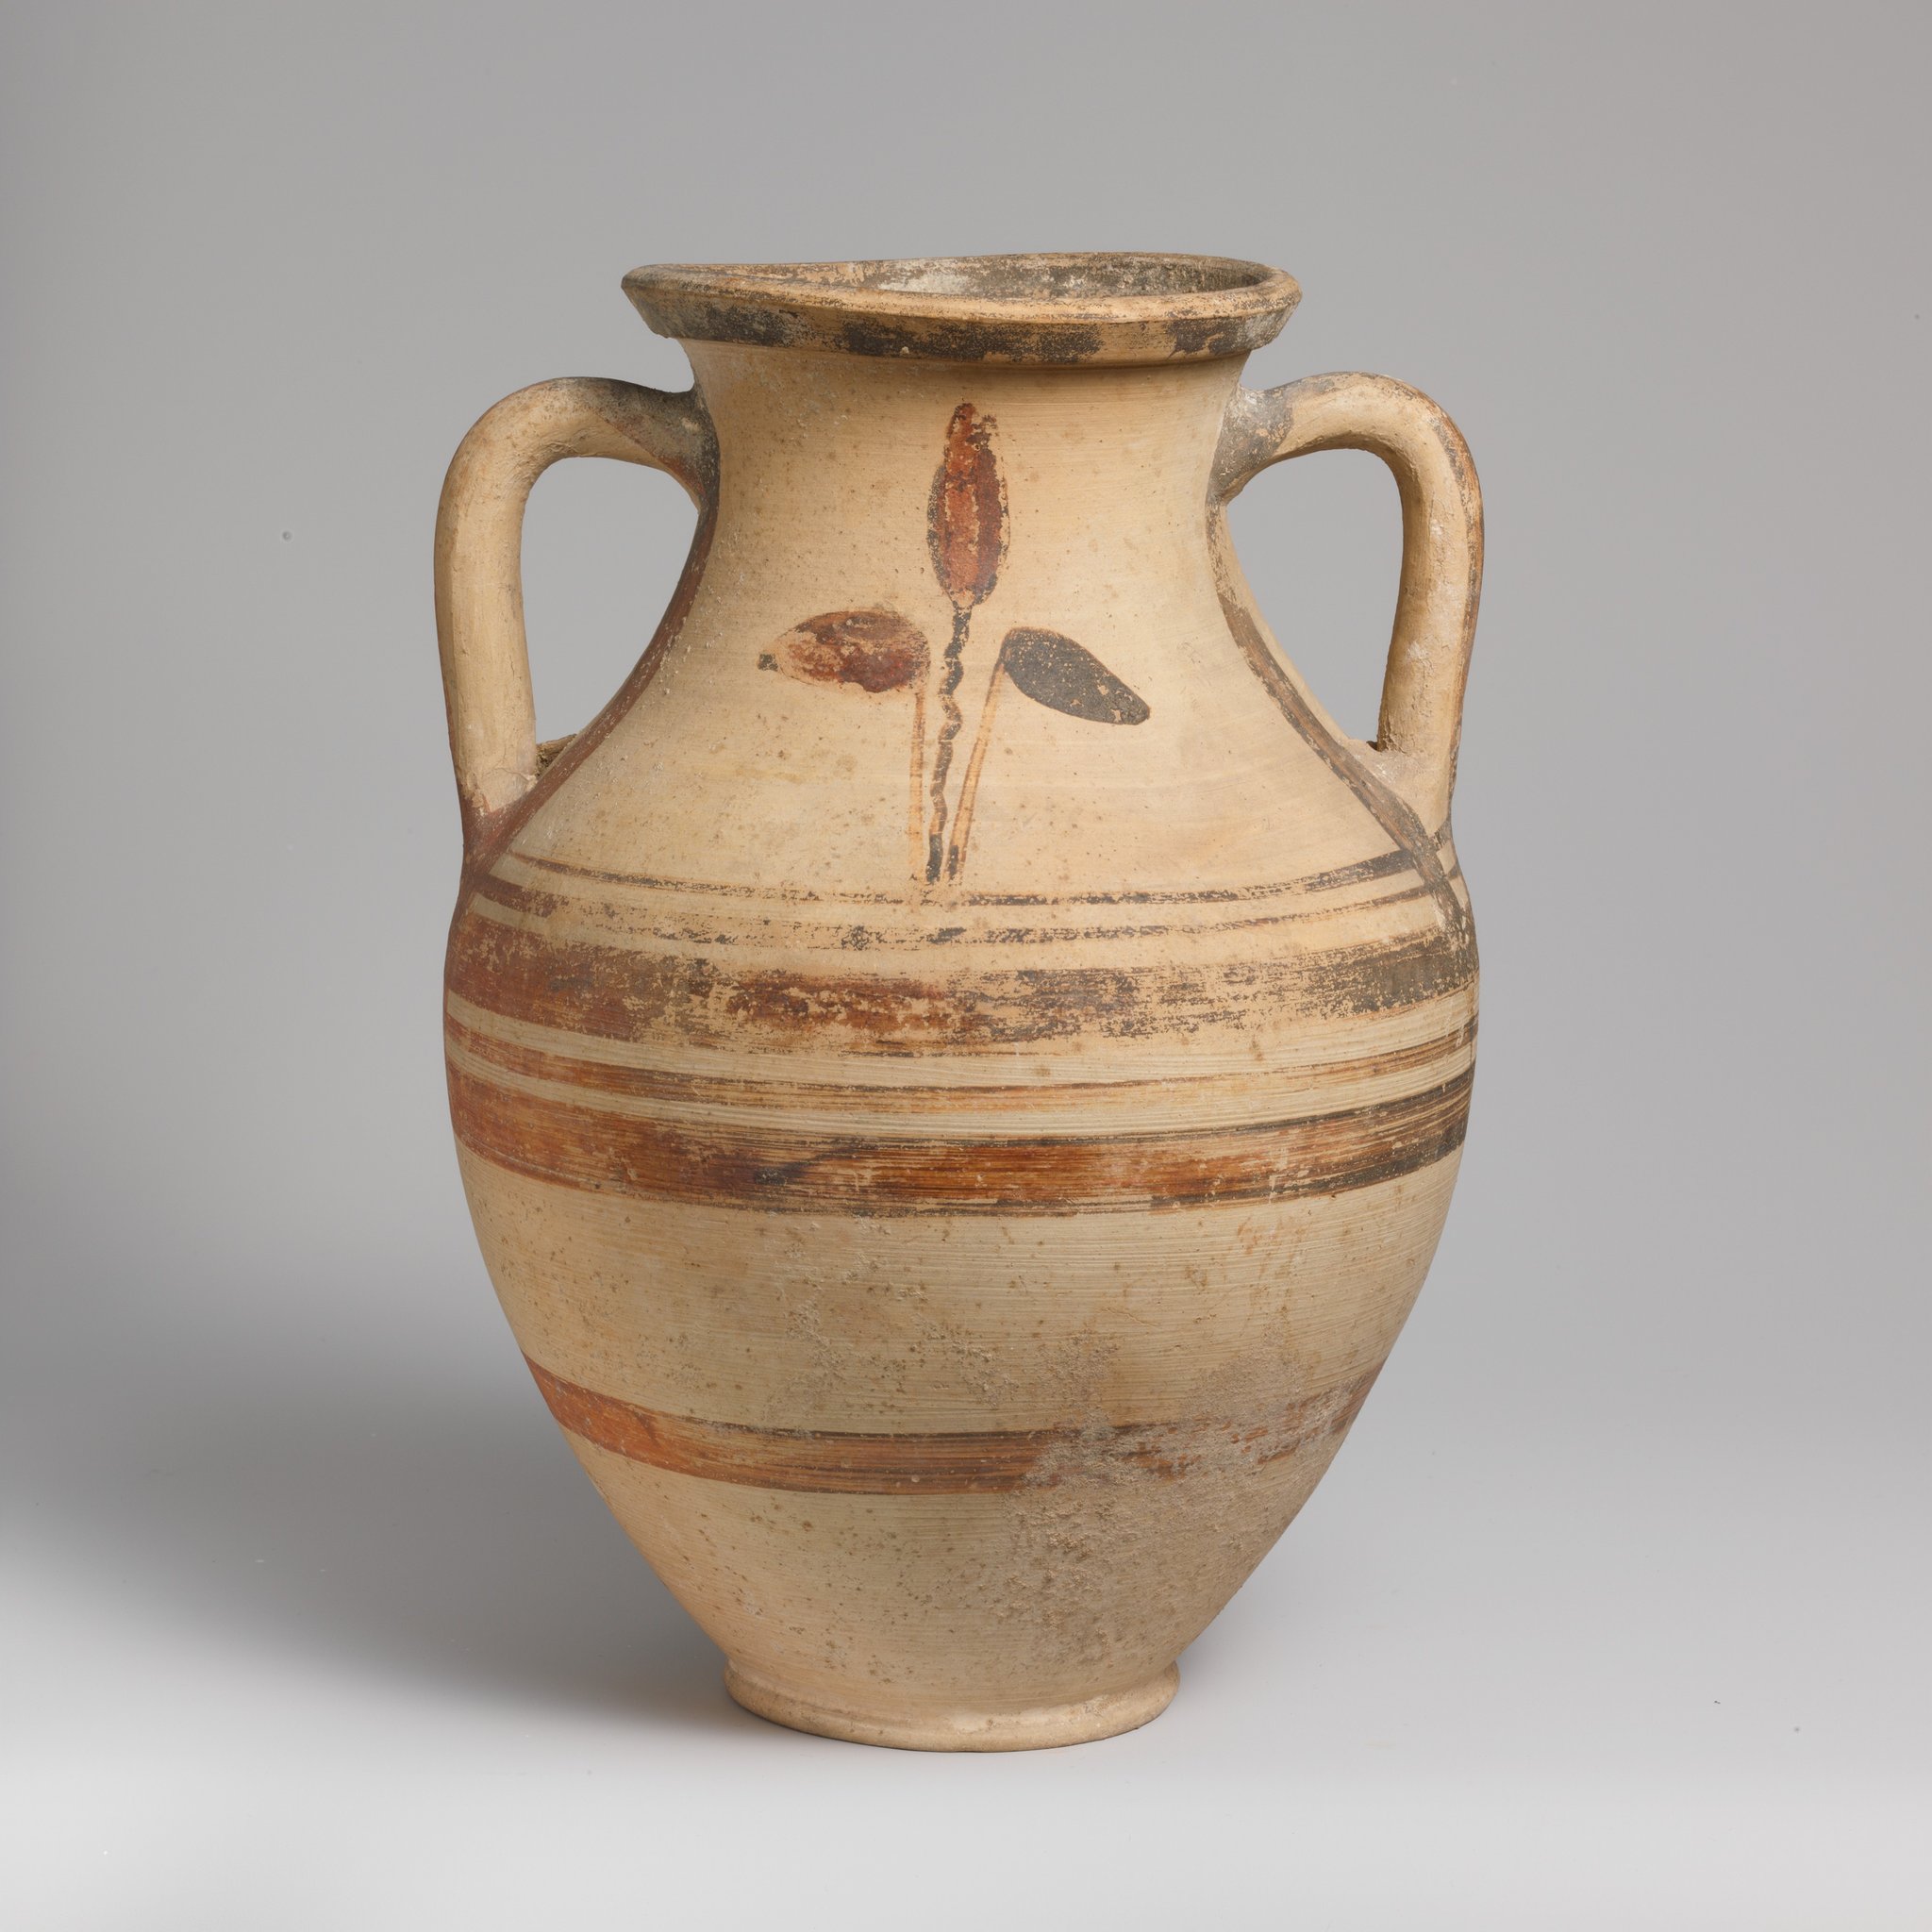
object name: amphora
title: Terracotta amphora (jar)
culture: east greek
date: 600-501 BCE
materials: terracotta